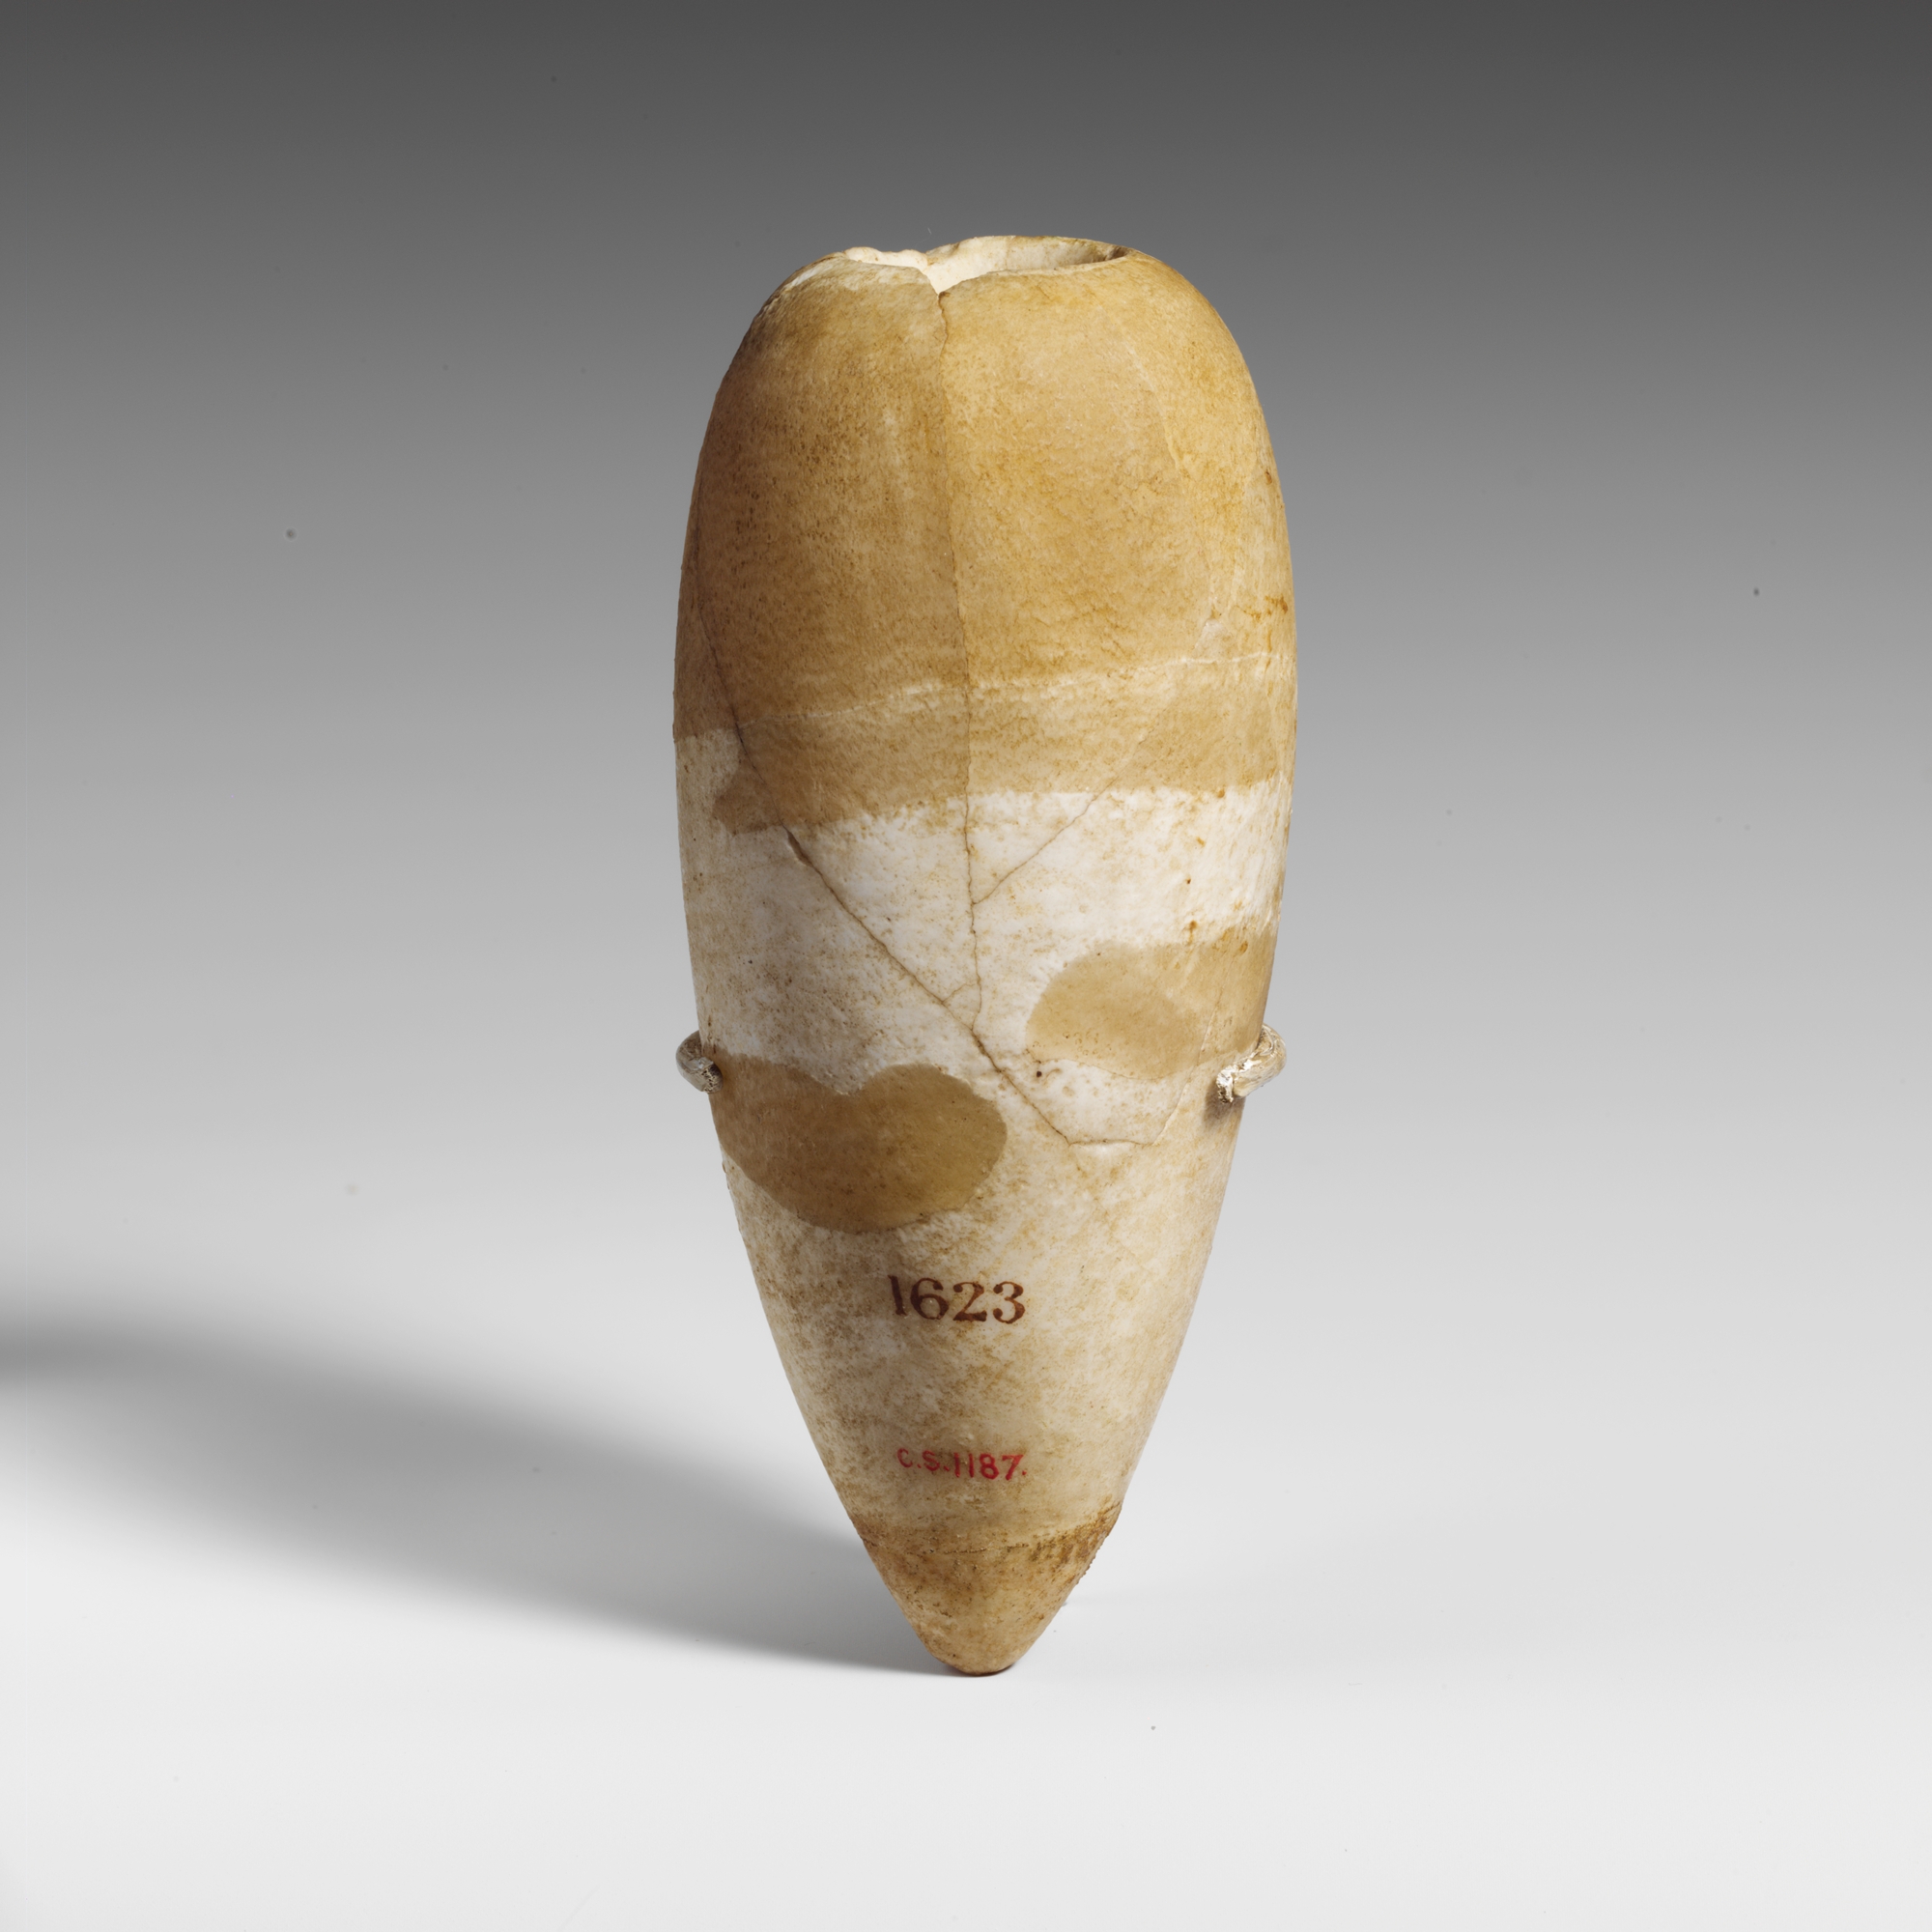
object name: vase, pear shaped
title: Alabaster pointed alabastron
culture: cypriot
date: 1600-1050 BCE